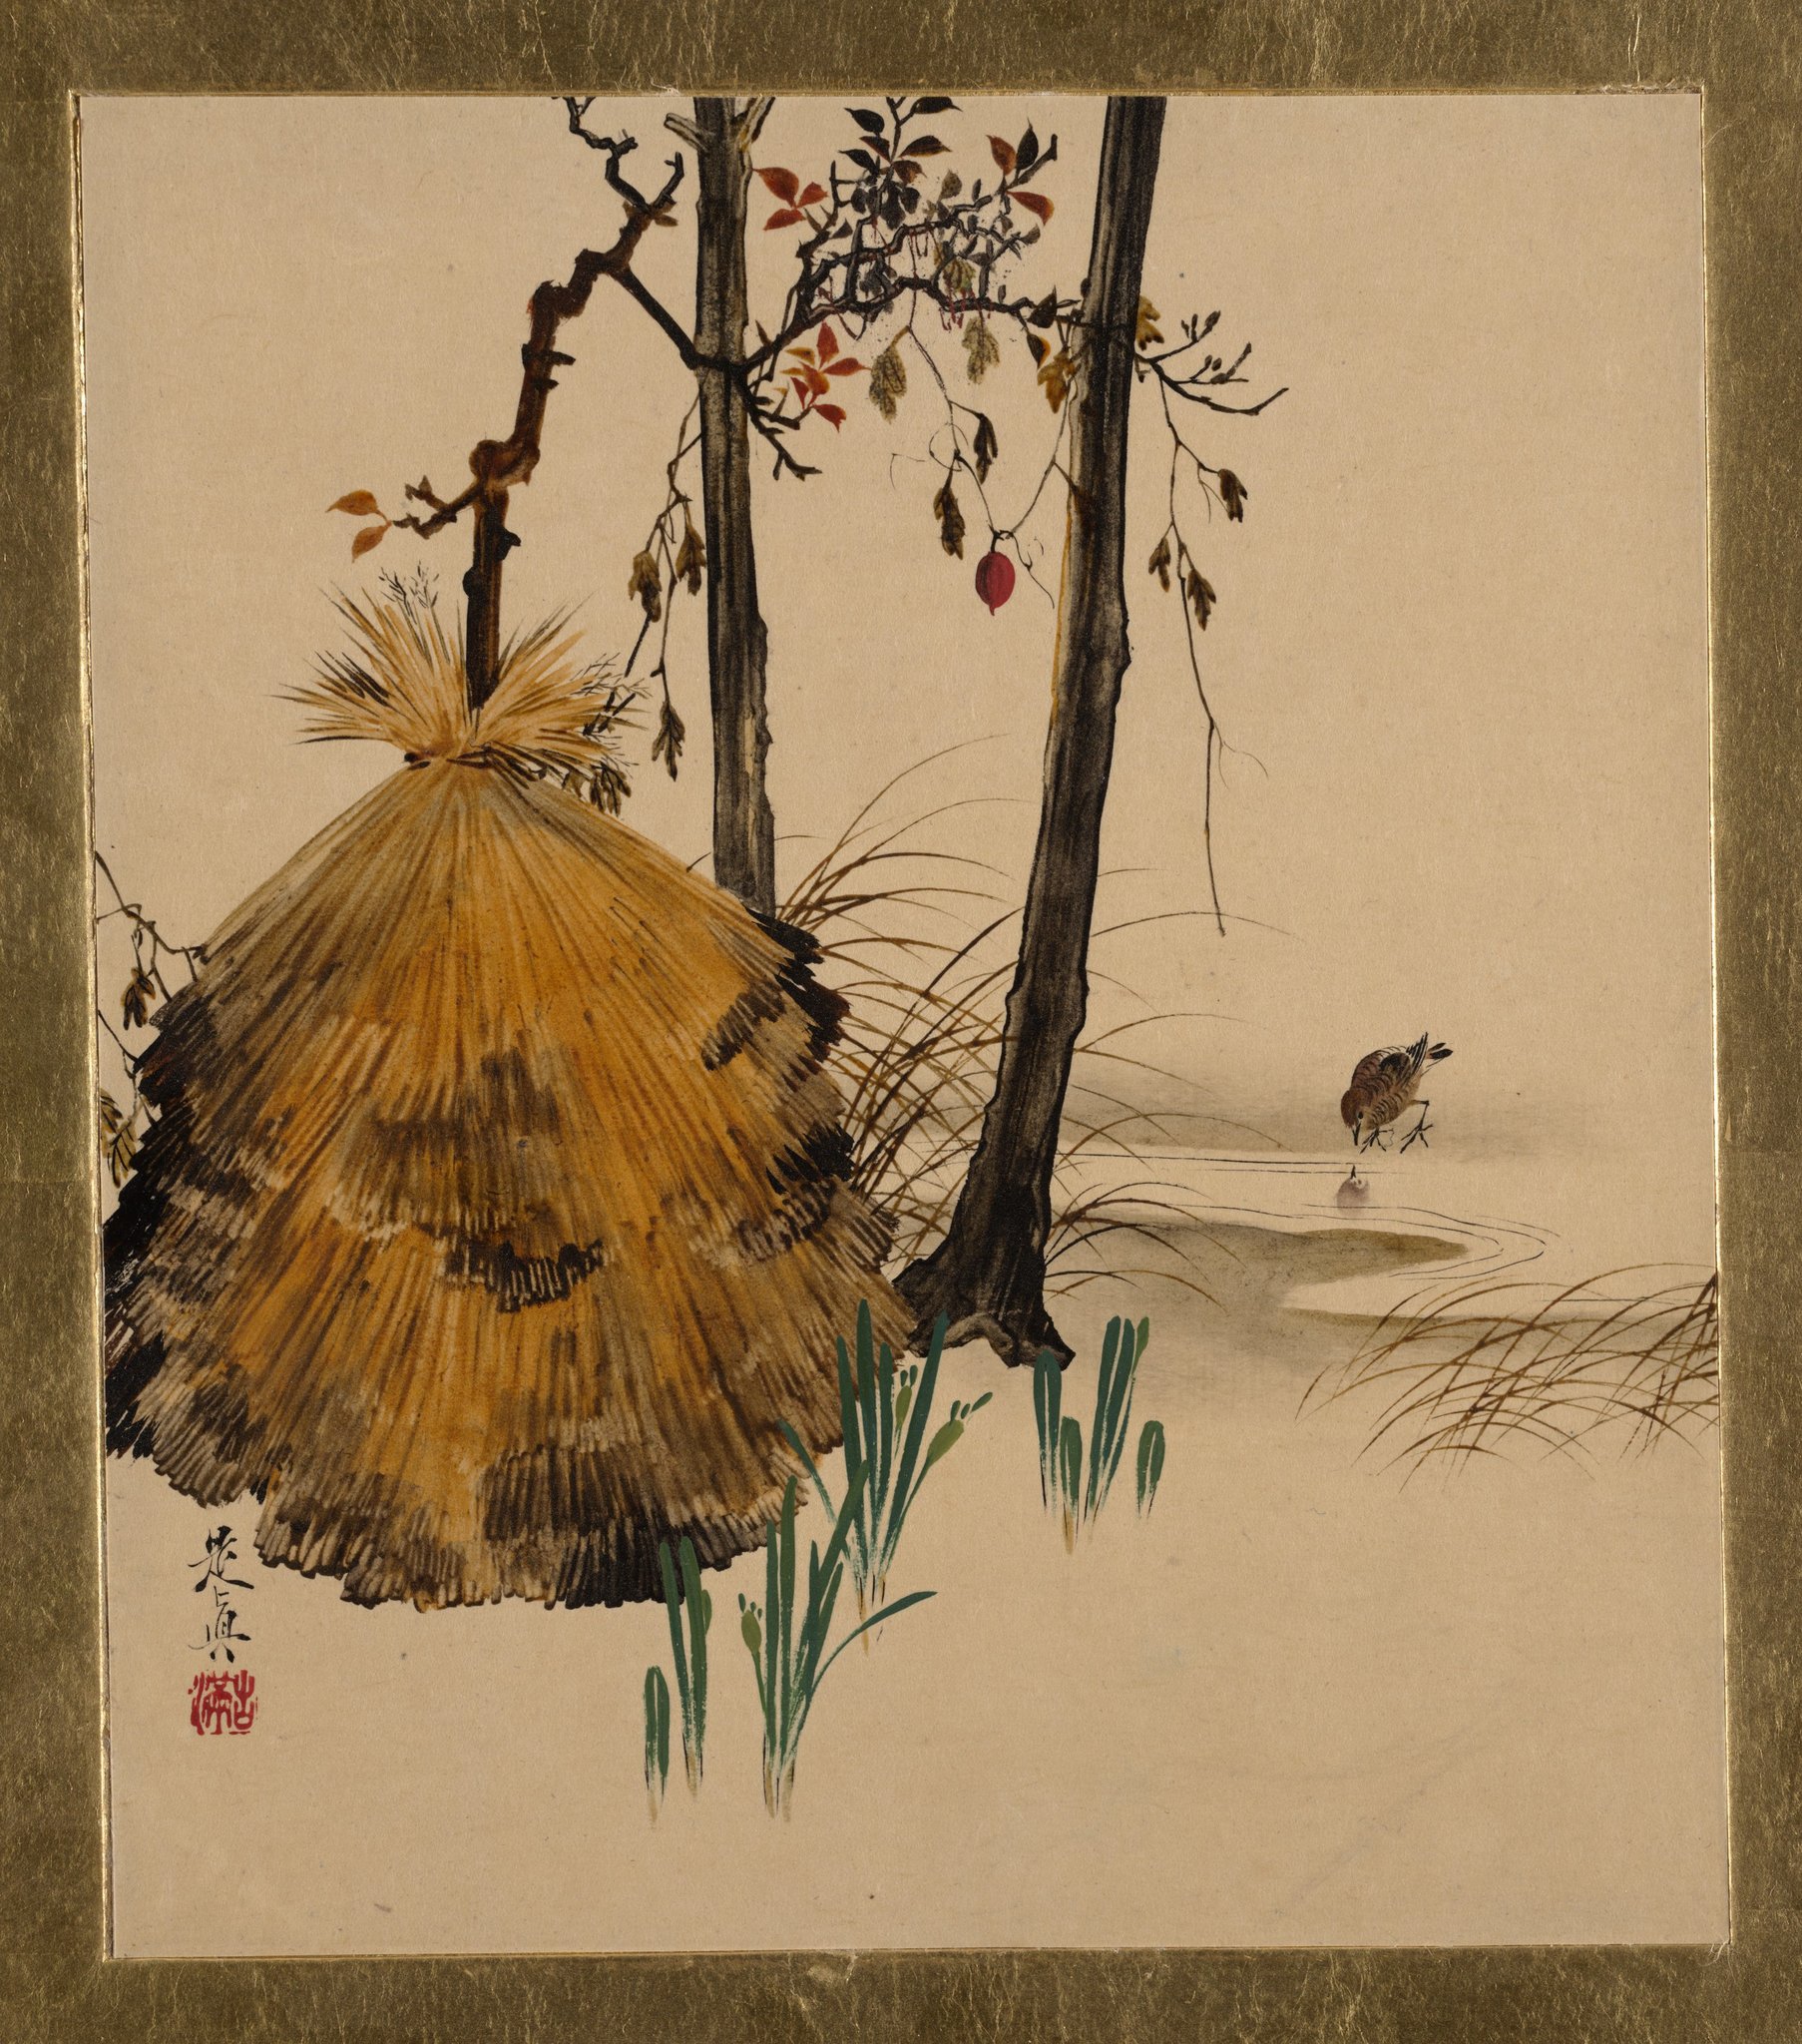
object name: painting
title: Lacquer Paintings of Various Subjects: Snow Shelter for a Tree with Sparrow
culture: japanese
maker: shibata zeshin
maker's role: artist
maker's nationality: japanese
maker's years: 1807-1891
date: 1882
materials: lacquer, paper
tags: birds,trees